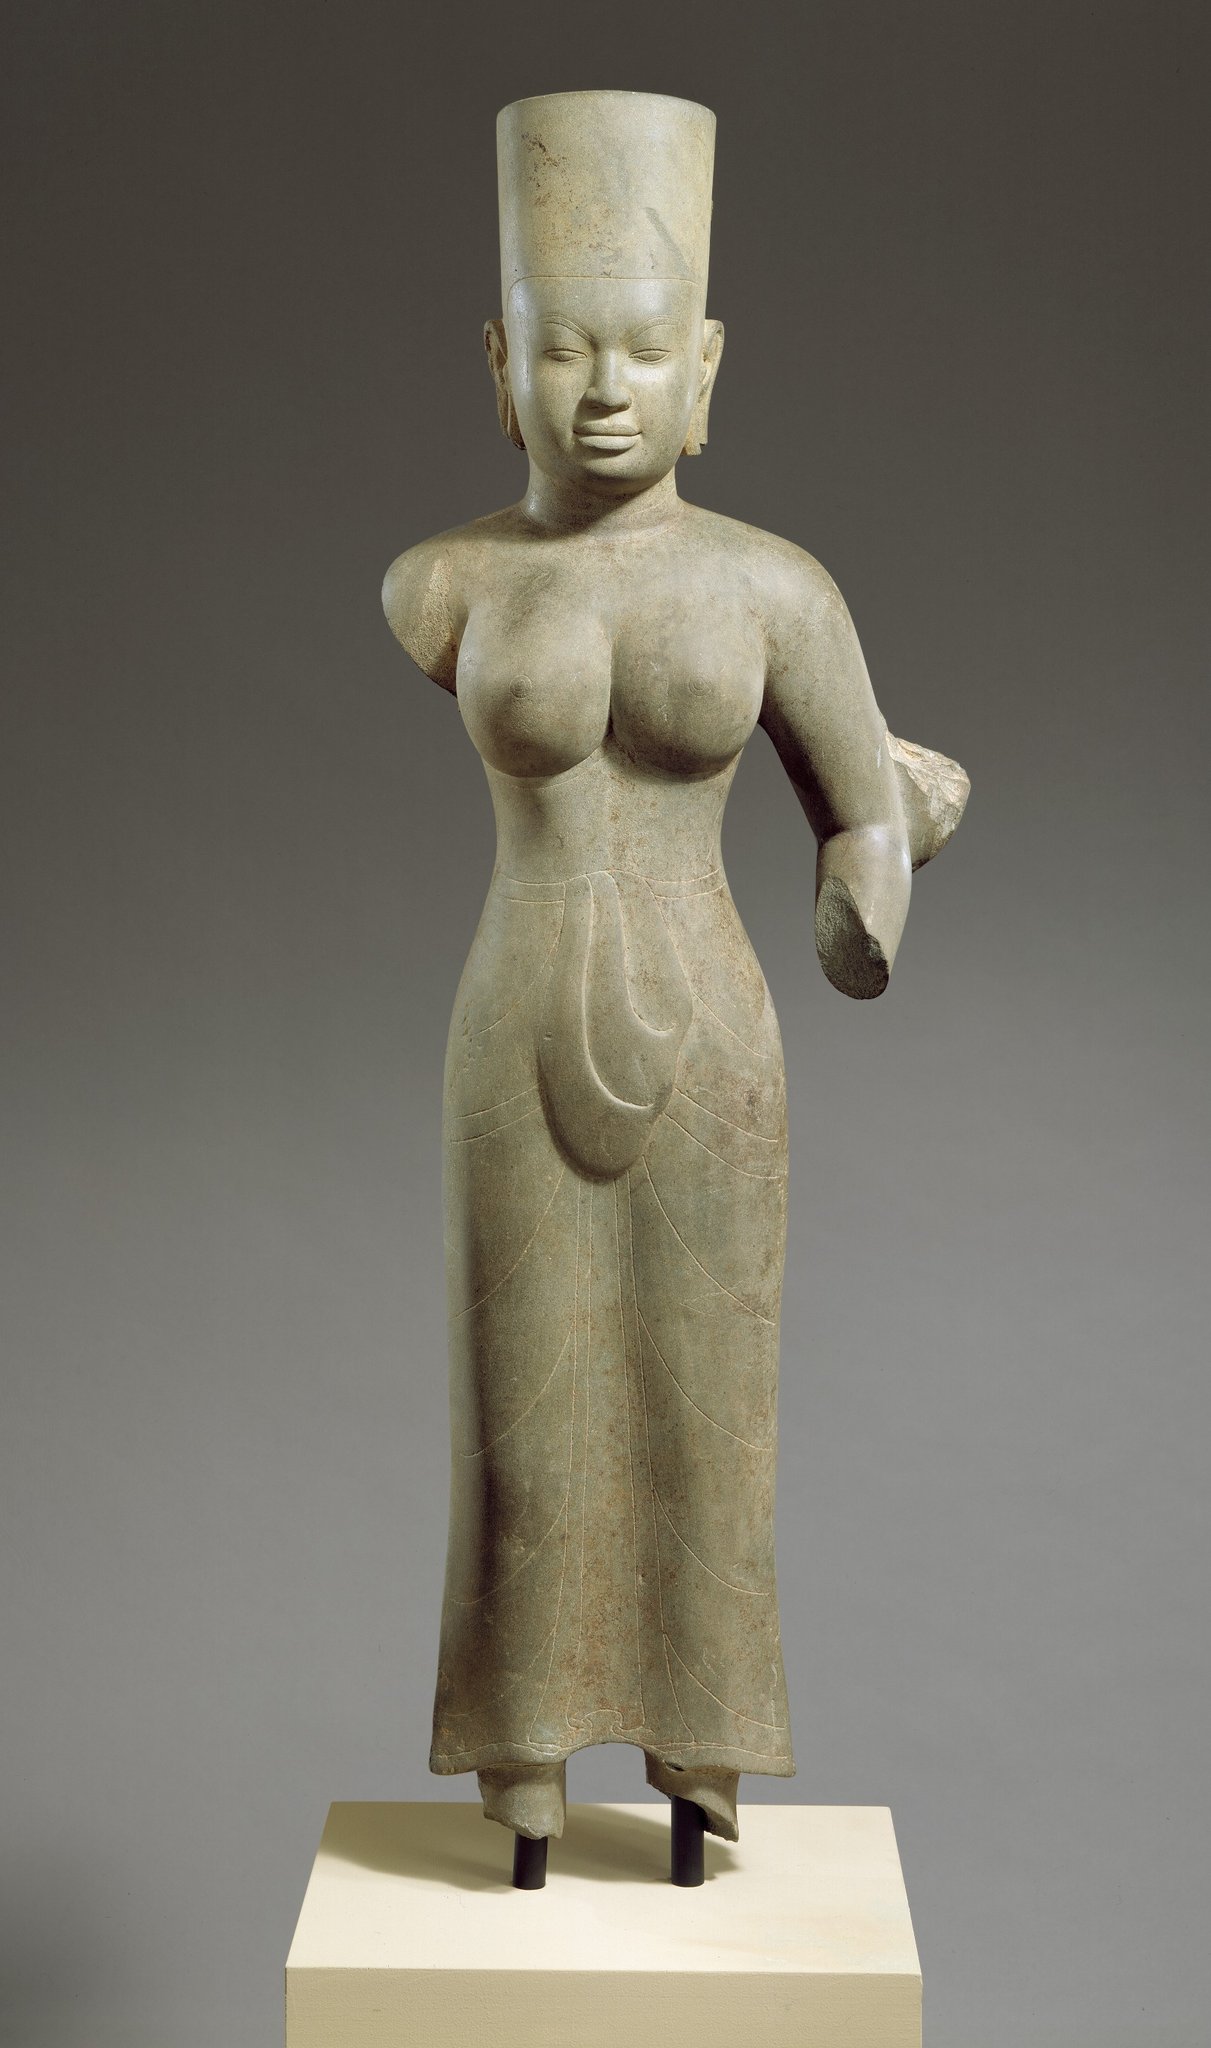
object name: figure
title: Standing Female Deity, probably Durga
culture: cambodian or vietnamese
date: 676-700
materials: stone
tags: durga